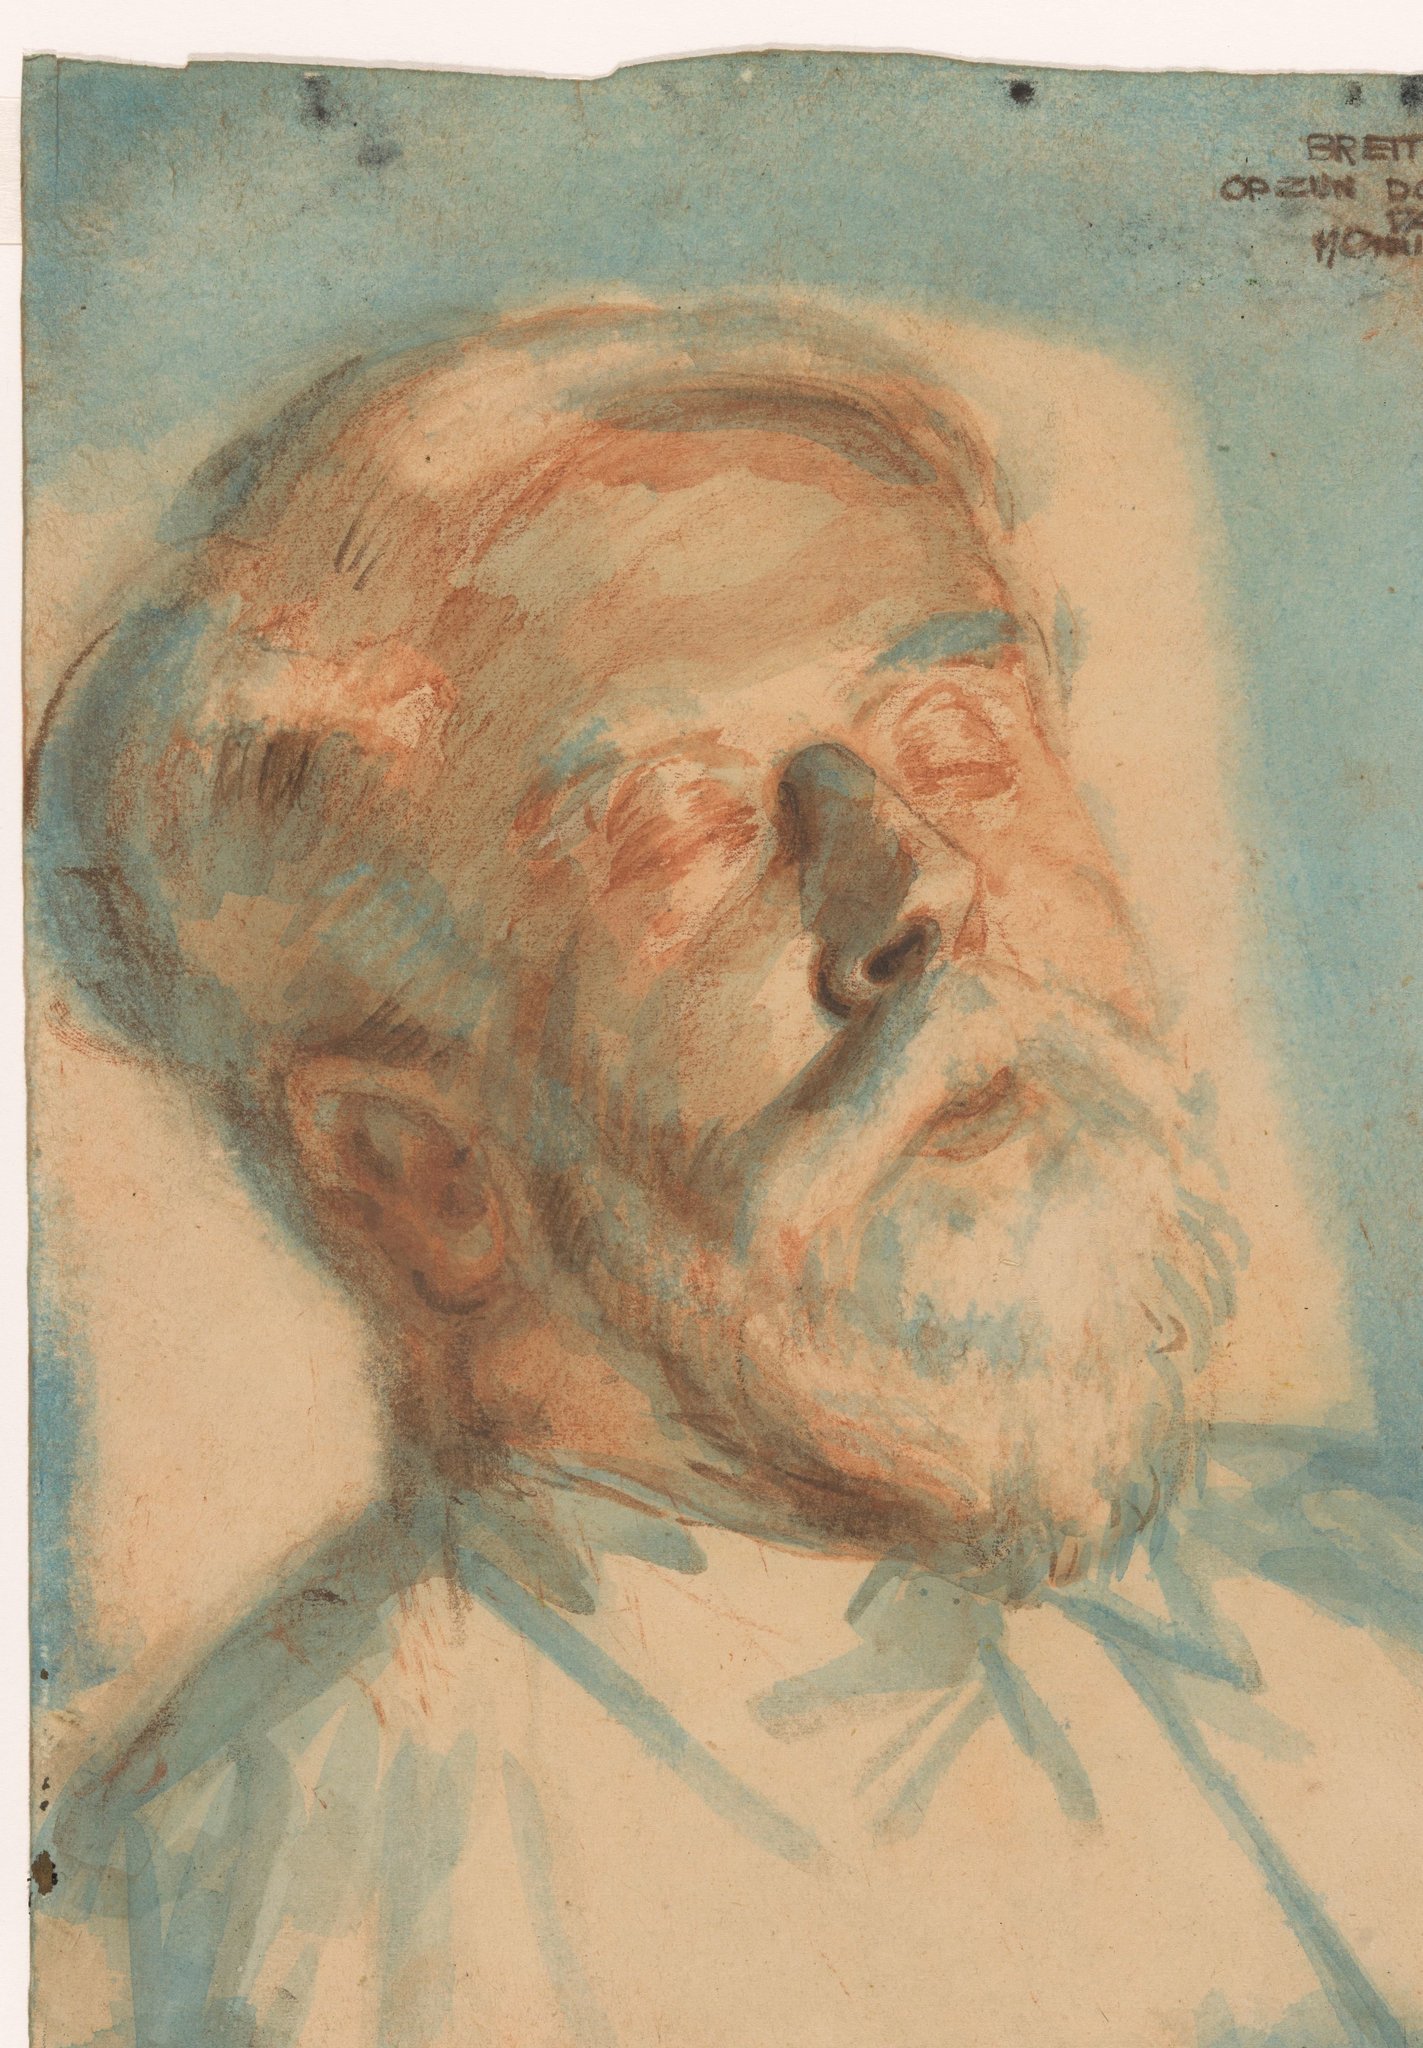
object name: drawing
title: Breitner op zijn doodsbed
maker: martin monnickendam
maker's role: draughtsman, painter, print maker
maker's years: 1874-1943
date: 1923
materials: chalk, paper, watercolor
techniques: brush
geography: amsterdam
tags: rotterdam, painter, print maker, george hendrik breitner, deathbed, historical persons, portrait, self-portrait of artist, artist on his deathbed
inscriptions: signature and date: ‘Martin Monnickendam // 1923’